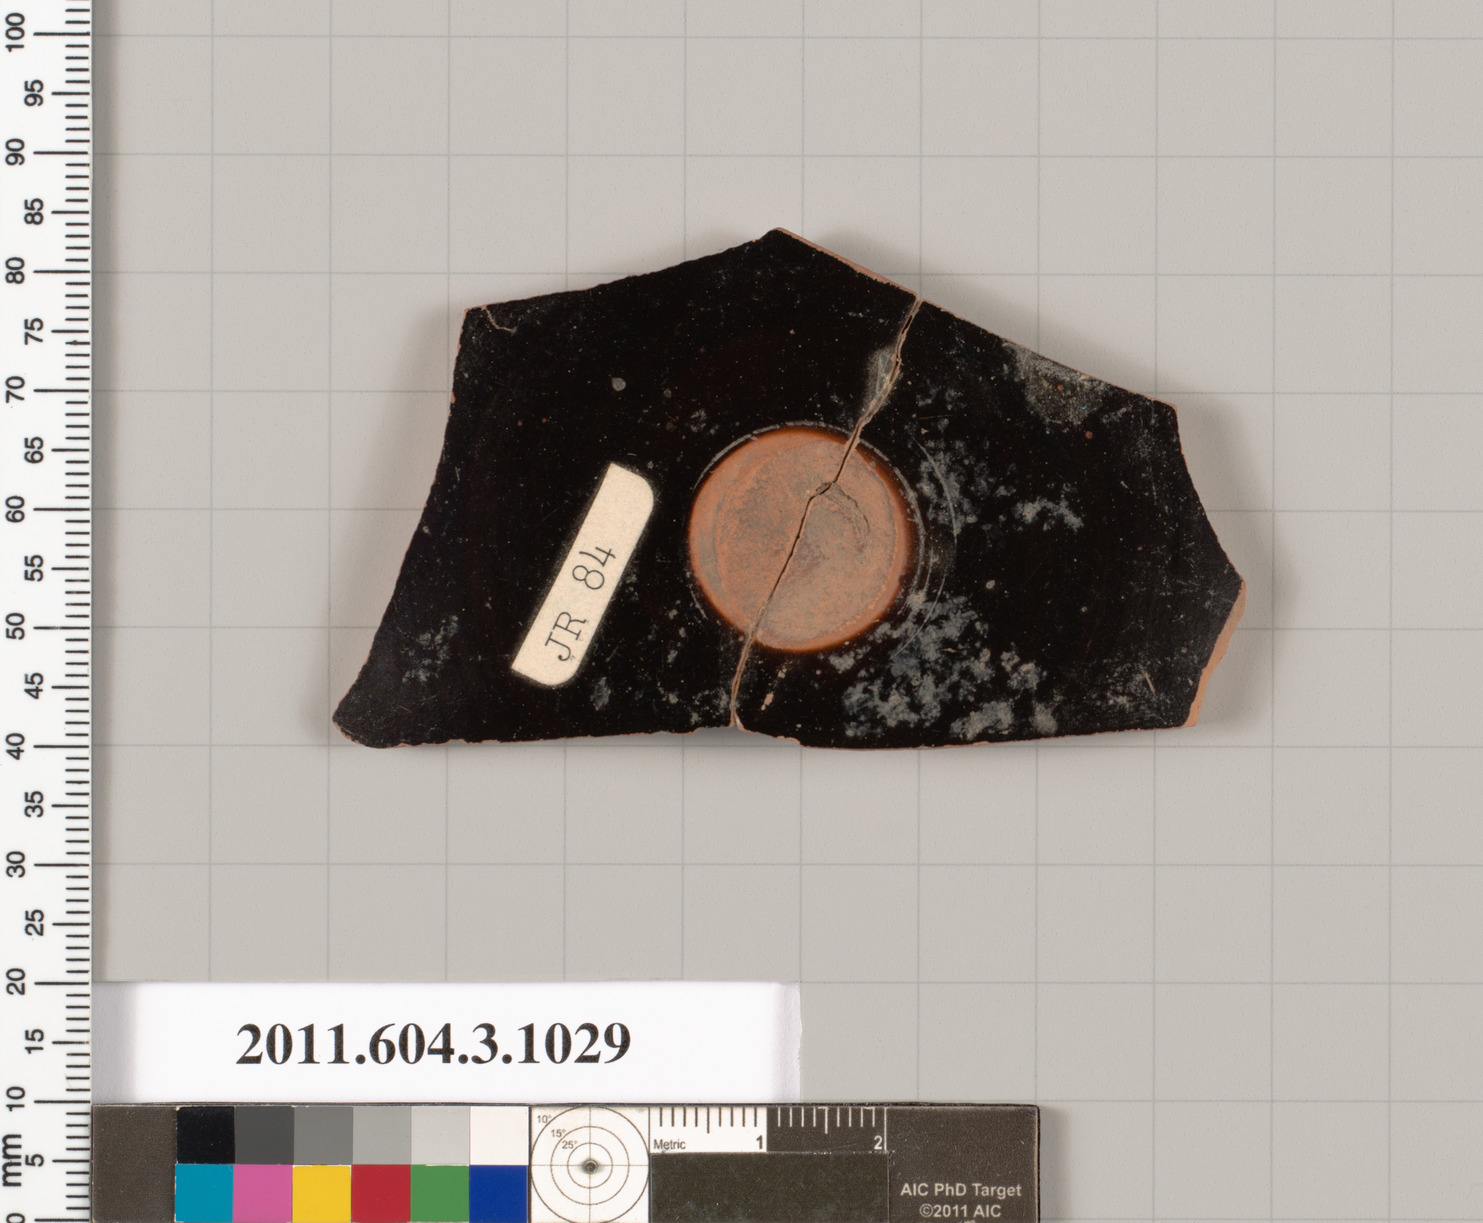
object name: lid fragment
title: Terracotta fragment of a lid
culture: greek, attic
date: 600-401 BCE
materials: terracotta